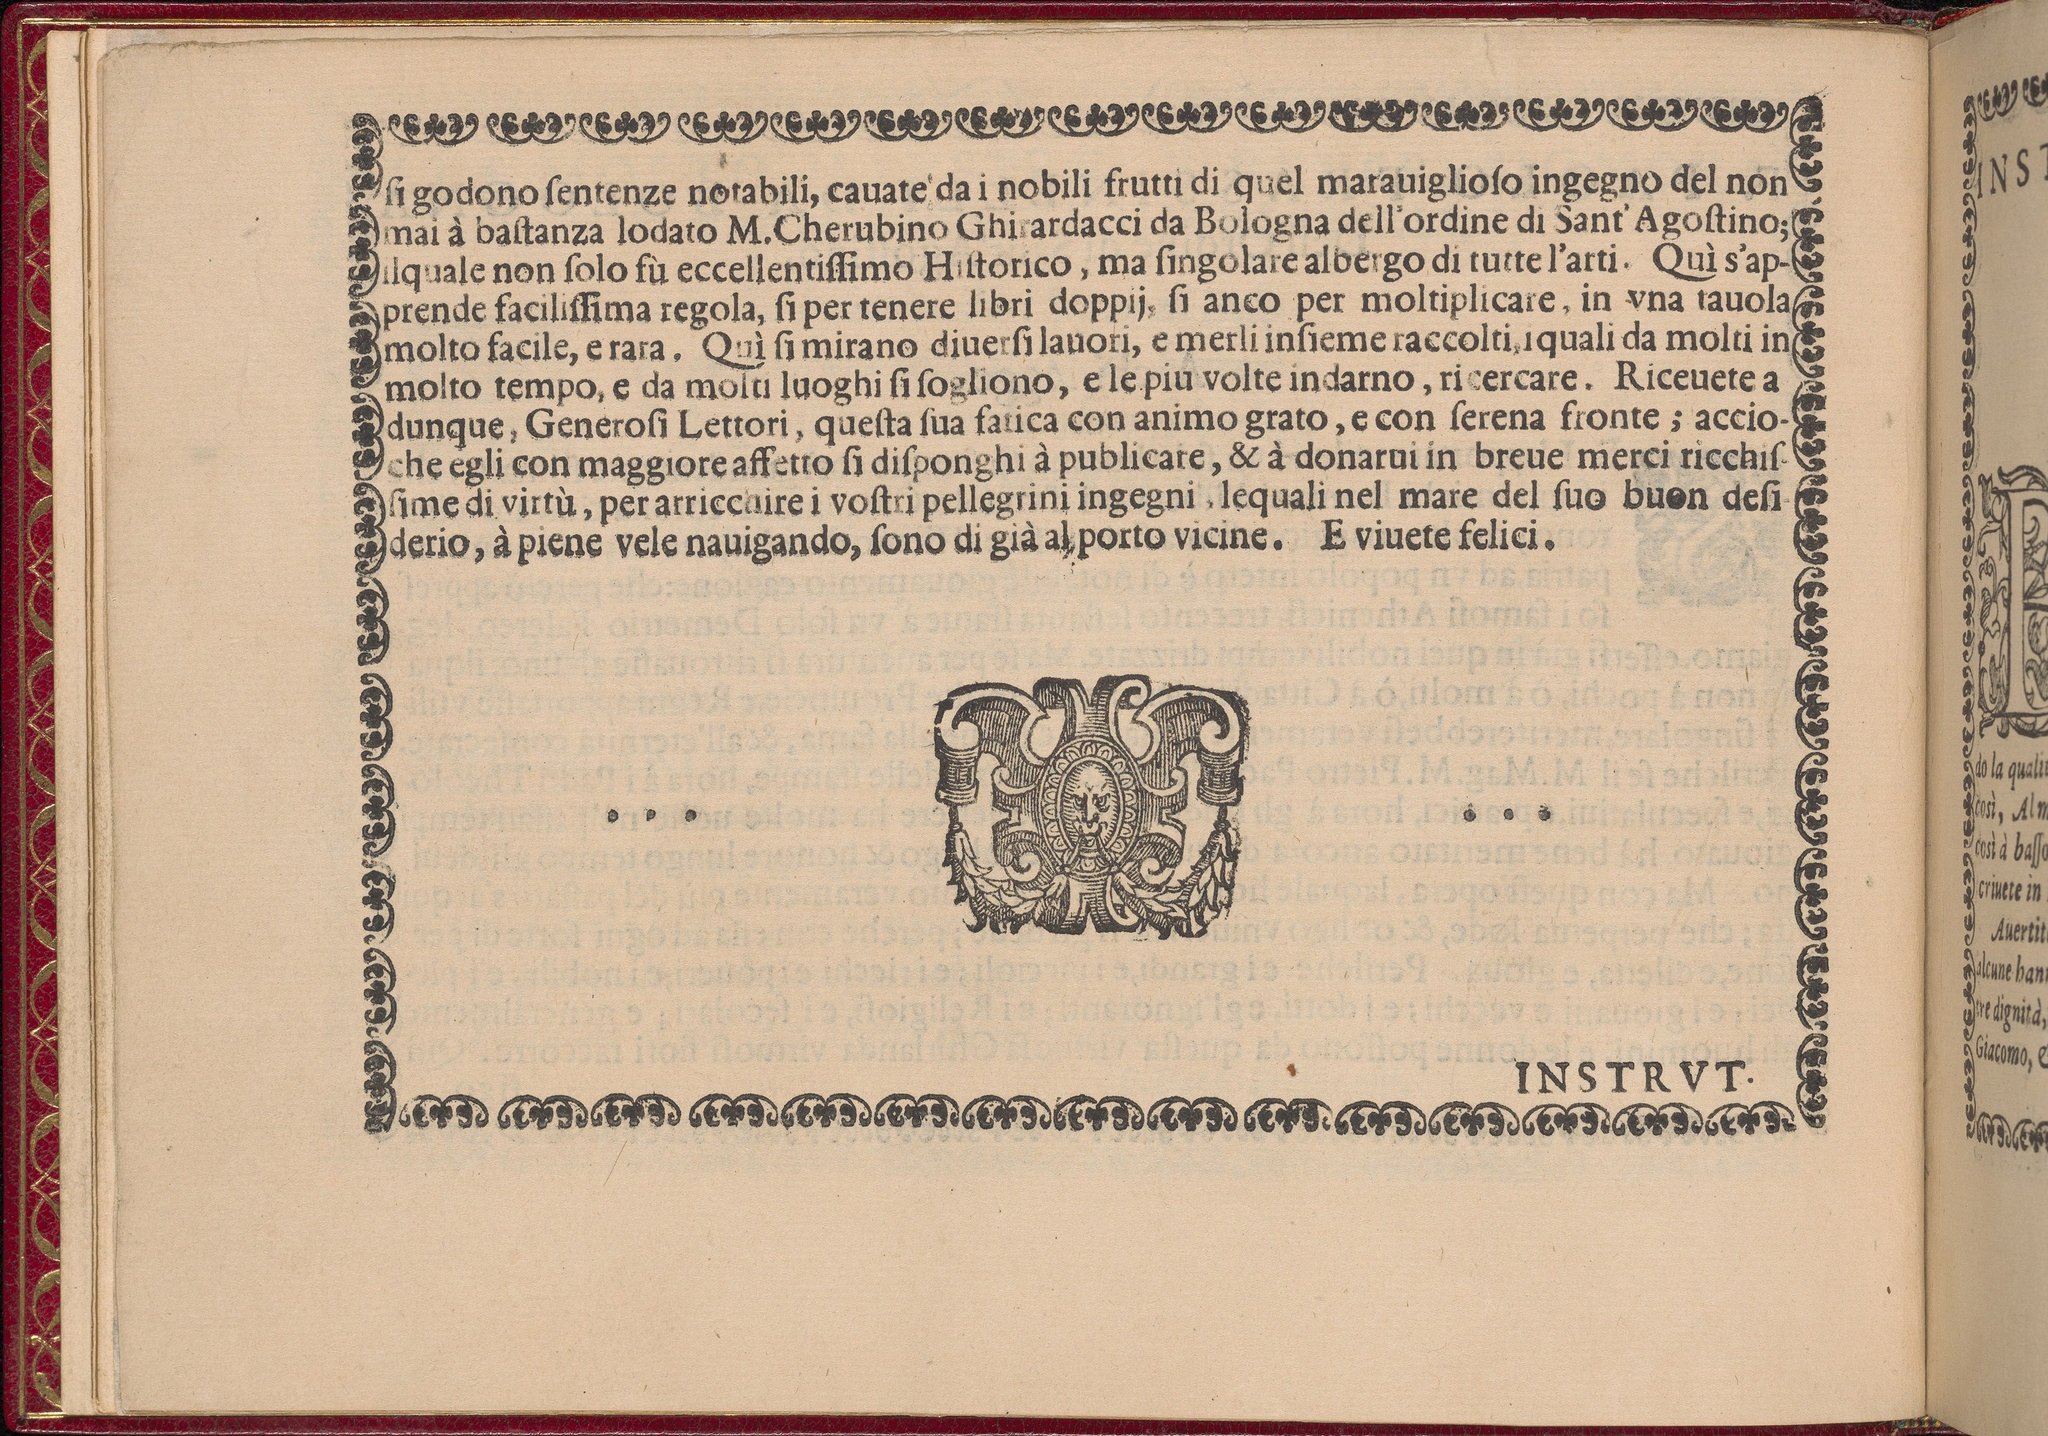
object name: book print ornament architecture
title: Ghirlanda: Di sei vaghi fiori scielti da piu famosi Giardini d'Italia, page 3 (verso)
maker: pietro paulo tozzi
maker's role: designer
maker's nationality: italian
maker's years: 1593-1628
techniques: drawing, etching